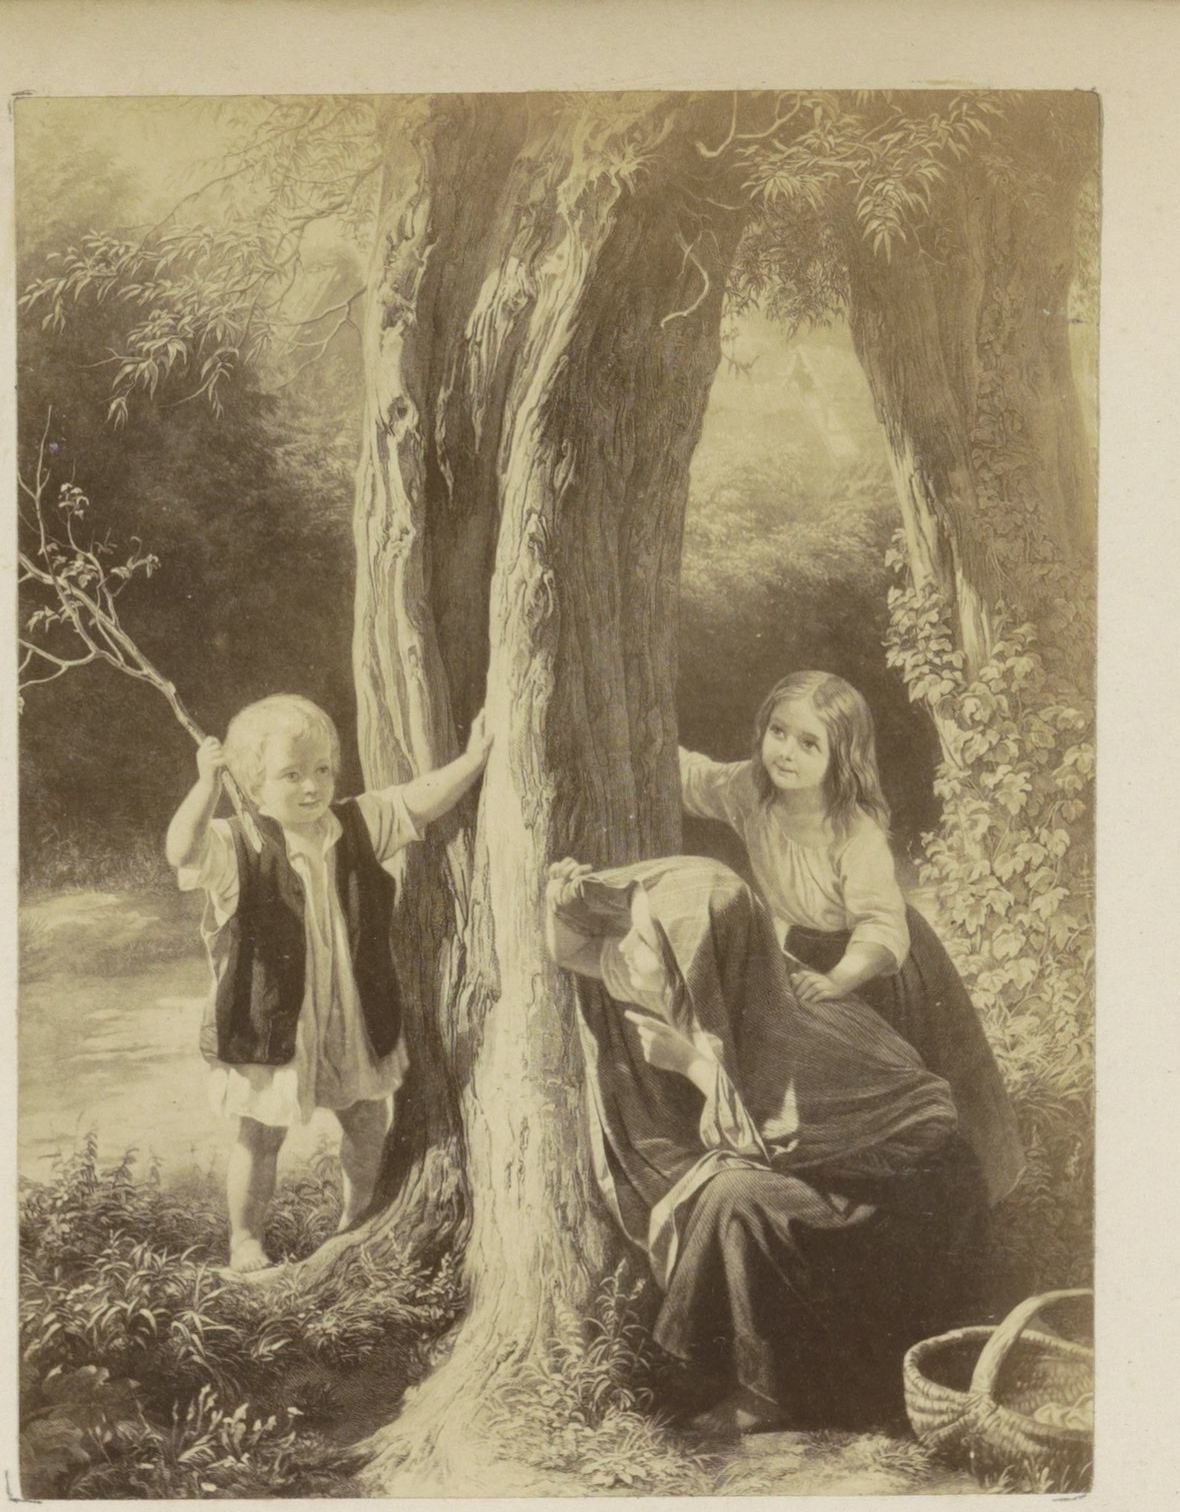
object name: photograph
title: Fotoreproductie van (vermoedelijk) een prent van in het bos spelende kinderen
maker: Anonymous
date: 1850-1870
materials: paper, photographic support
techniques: albumen print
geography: england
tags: 43c768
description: Onderdeel van Album met foto's van bezienswaardigheden en landschappen in Engeland en van kunst.